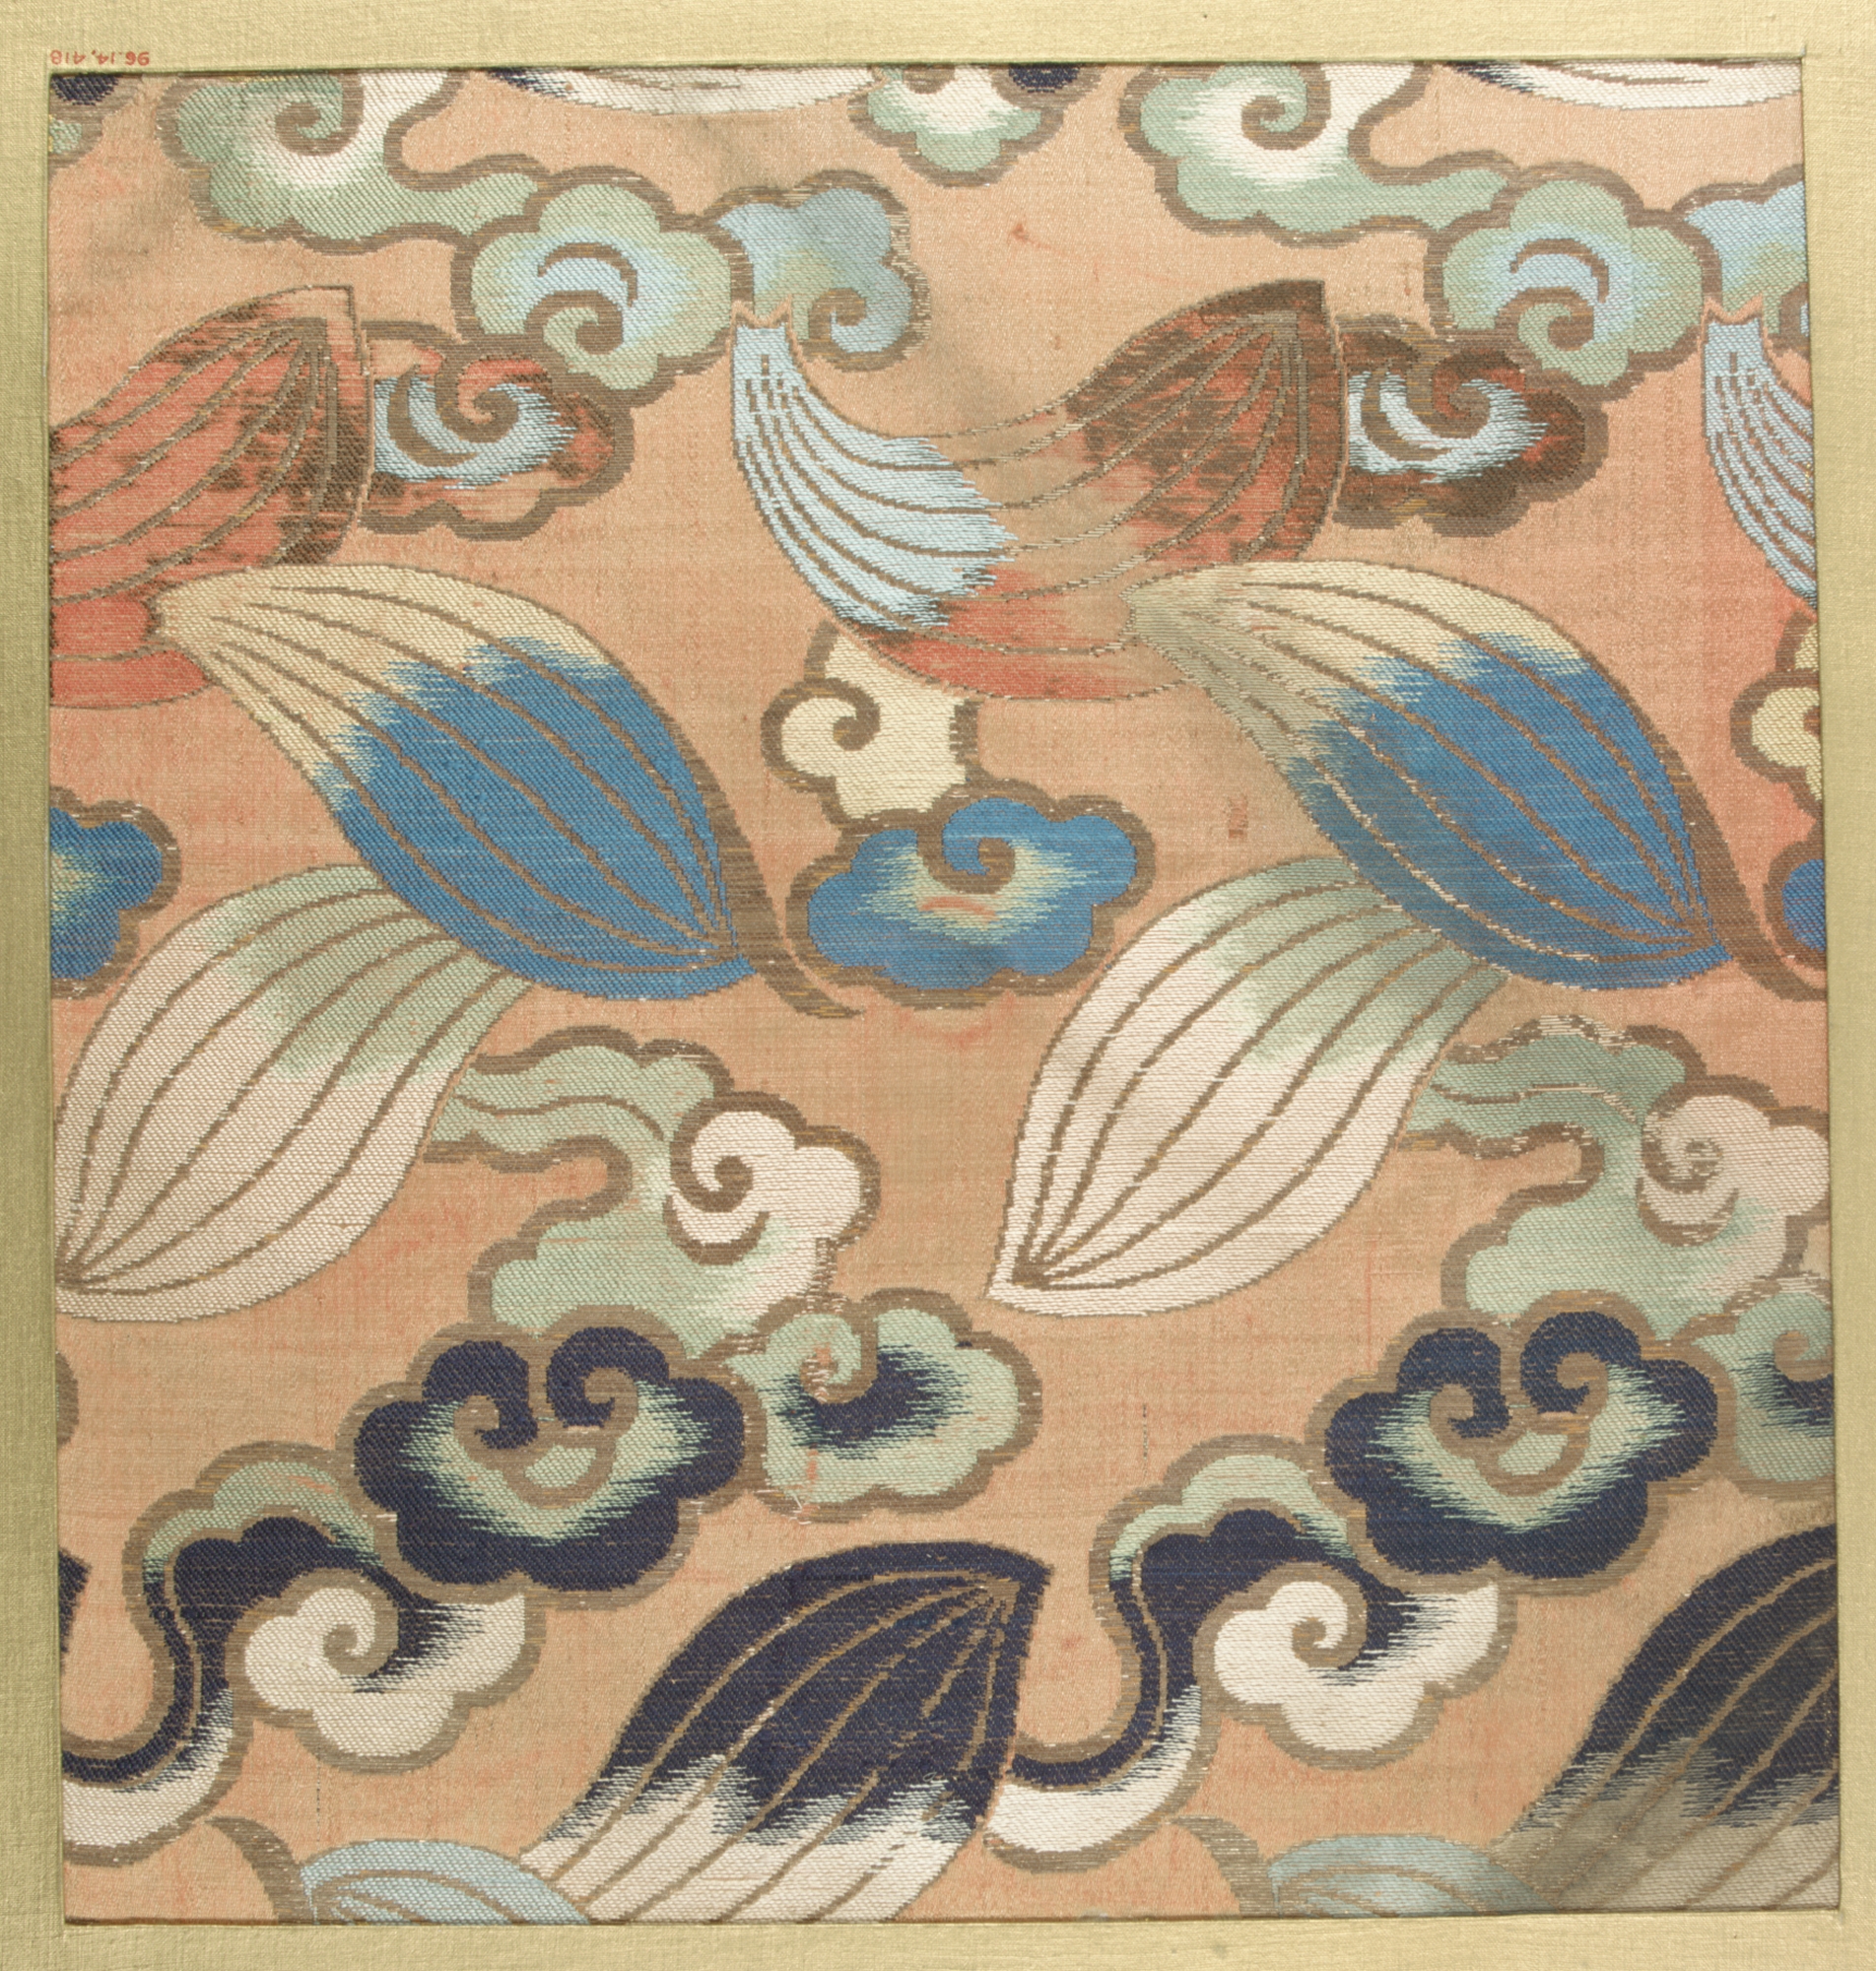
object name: piece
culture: japanese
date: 1701-1900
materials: silk